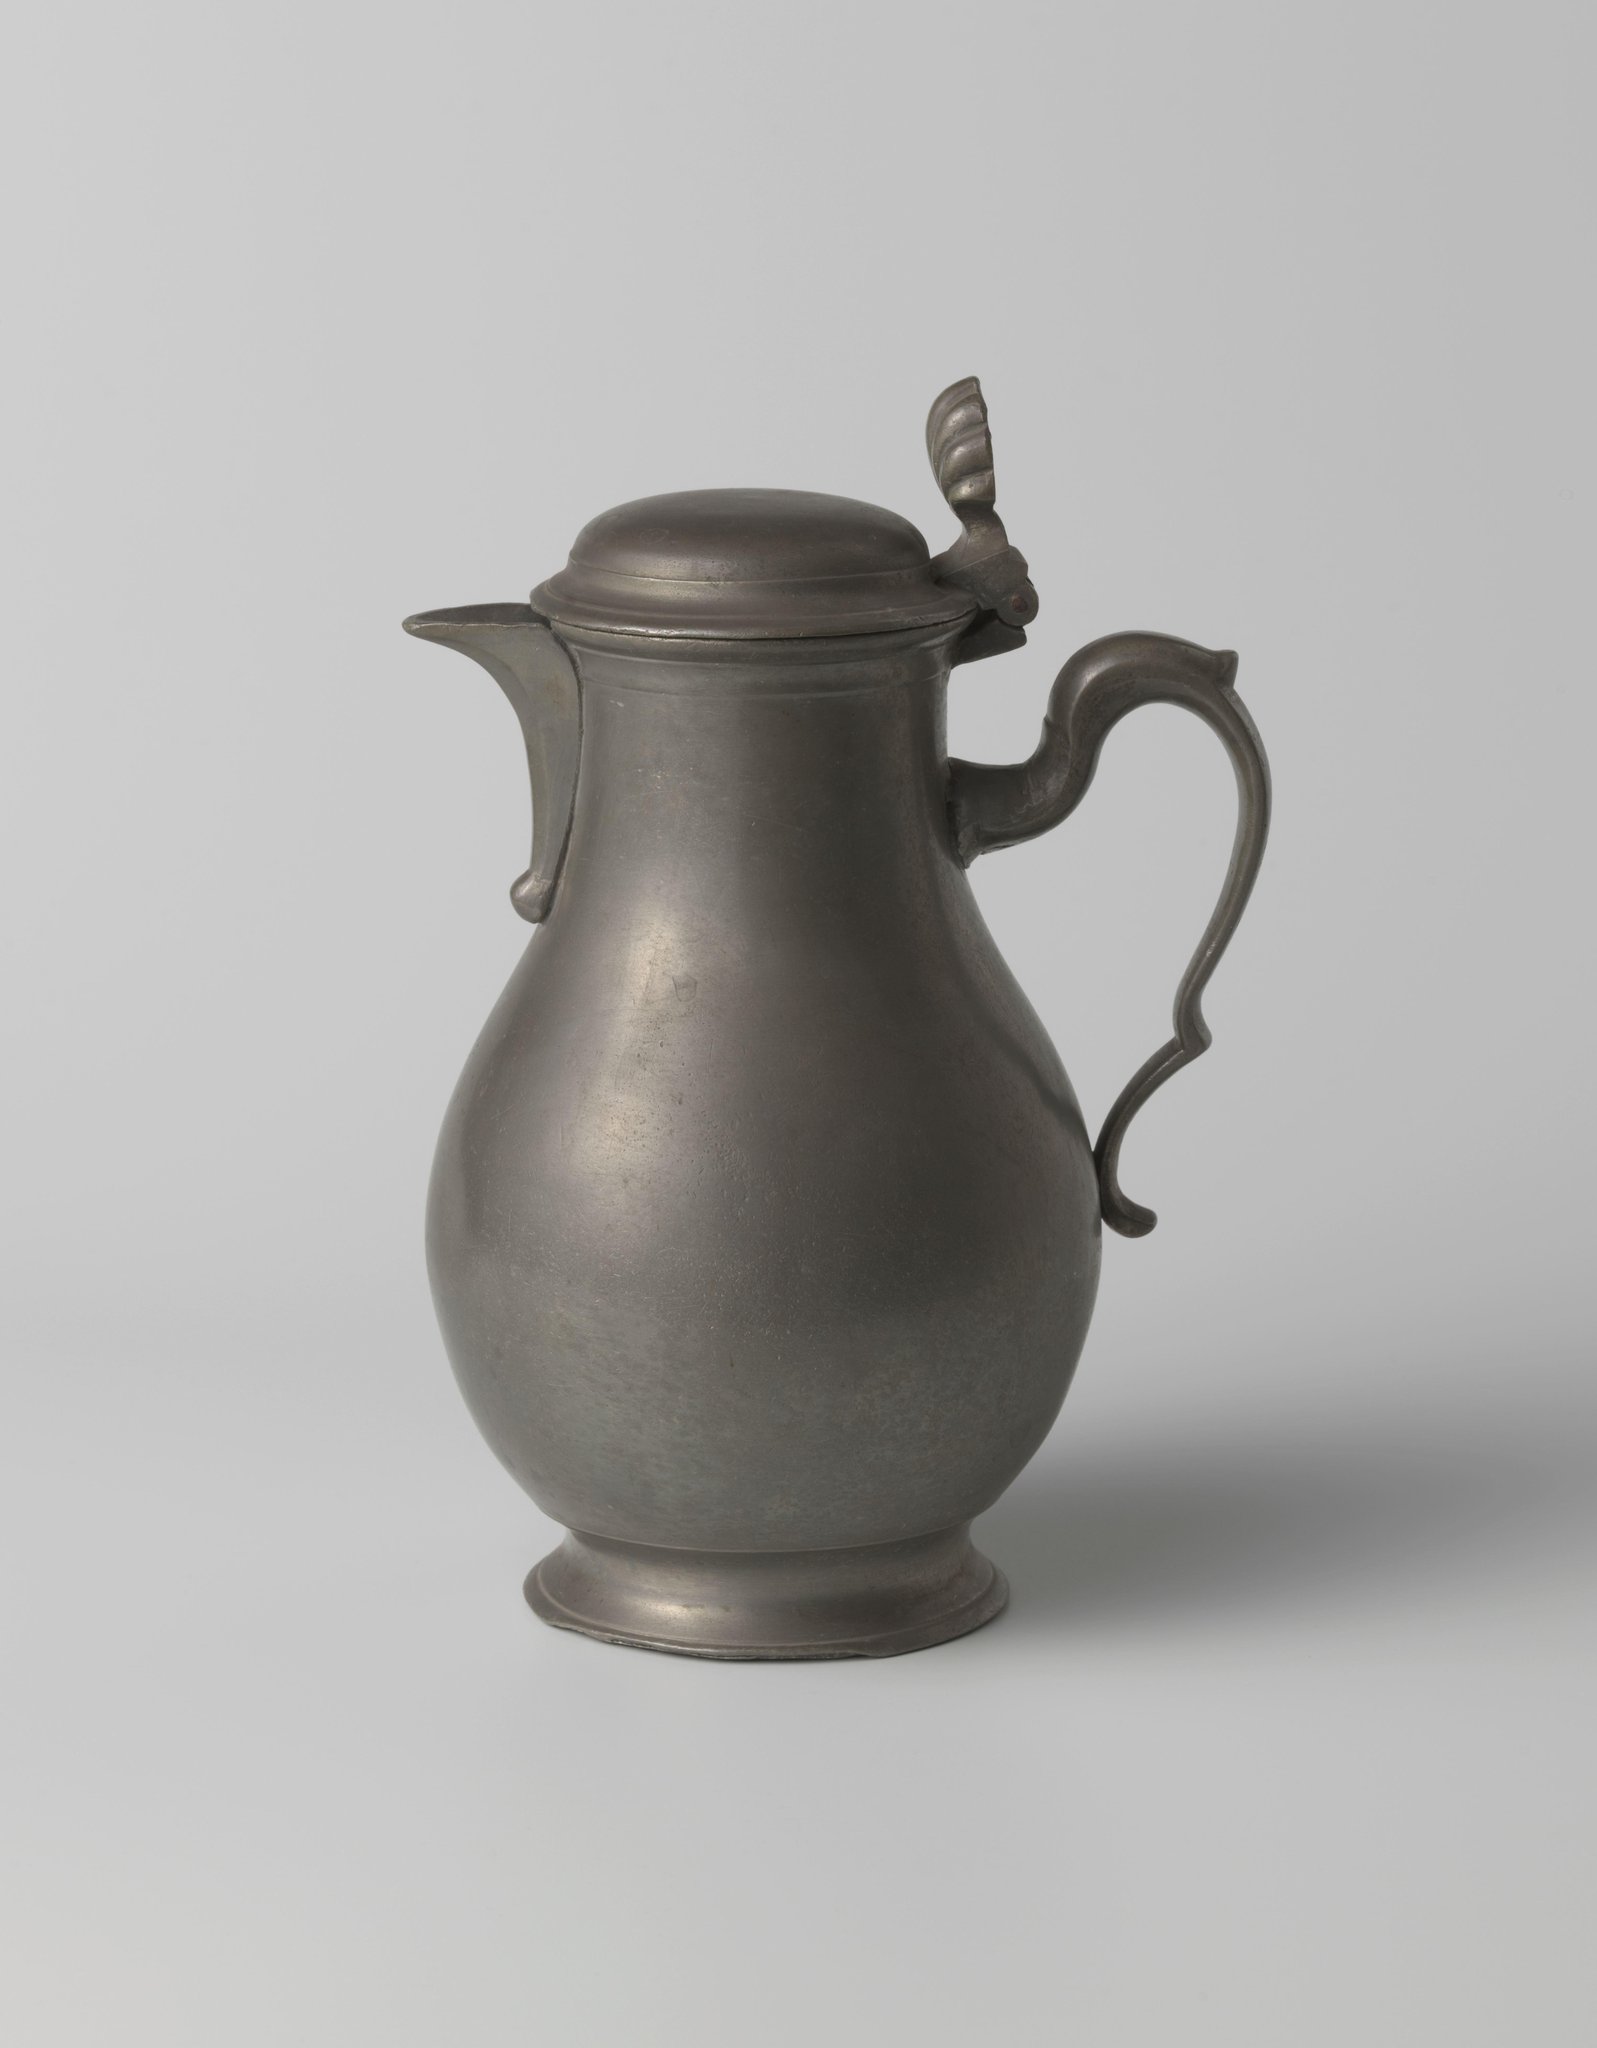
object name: flagon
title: Schenkkan van tin met deksel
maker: Anonymous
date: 1600-1699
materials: tin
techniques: casting, turning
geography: low countries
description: Schenkkan van tin. De voet draagt een peervormige lichaam met sneb. De bovenzijde wordt afgesloten met een licht gewelfd deksel, dat kan en sneb bedekt. Het schelpvormige duimrust heeft een dubbelkakig scharnier. Het accoladevormige handvat begint in de hals van de kan en loopt door tot aan het dikste punt van de buik. Vanuit een bol ontspringt de korte, vijfzijdige schenktuit.